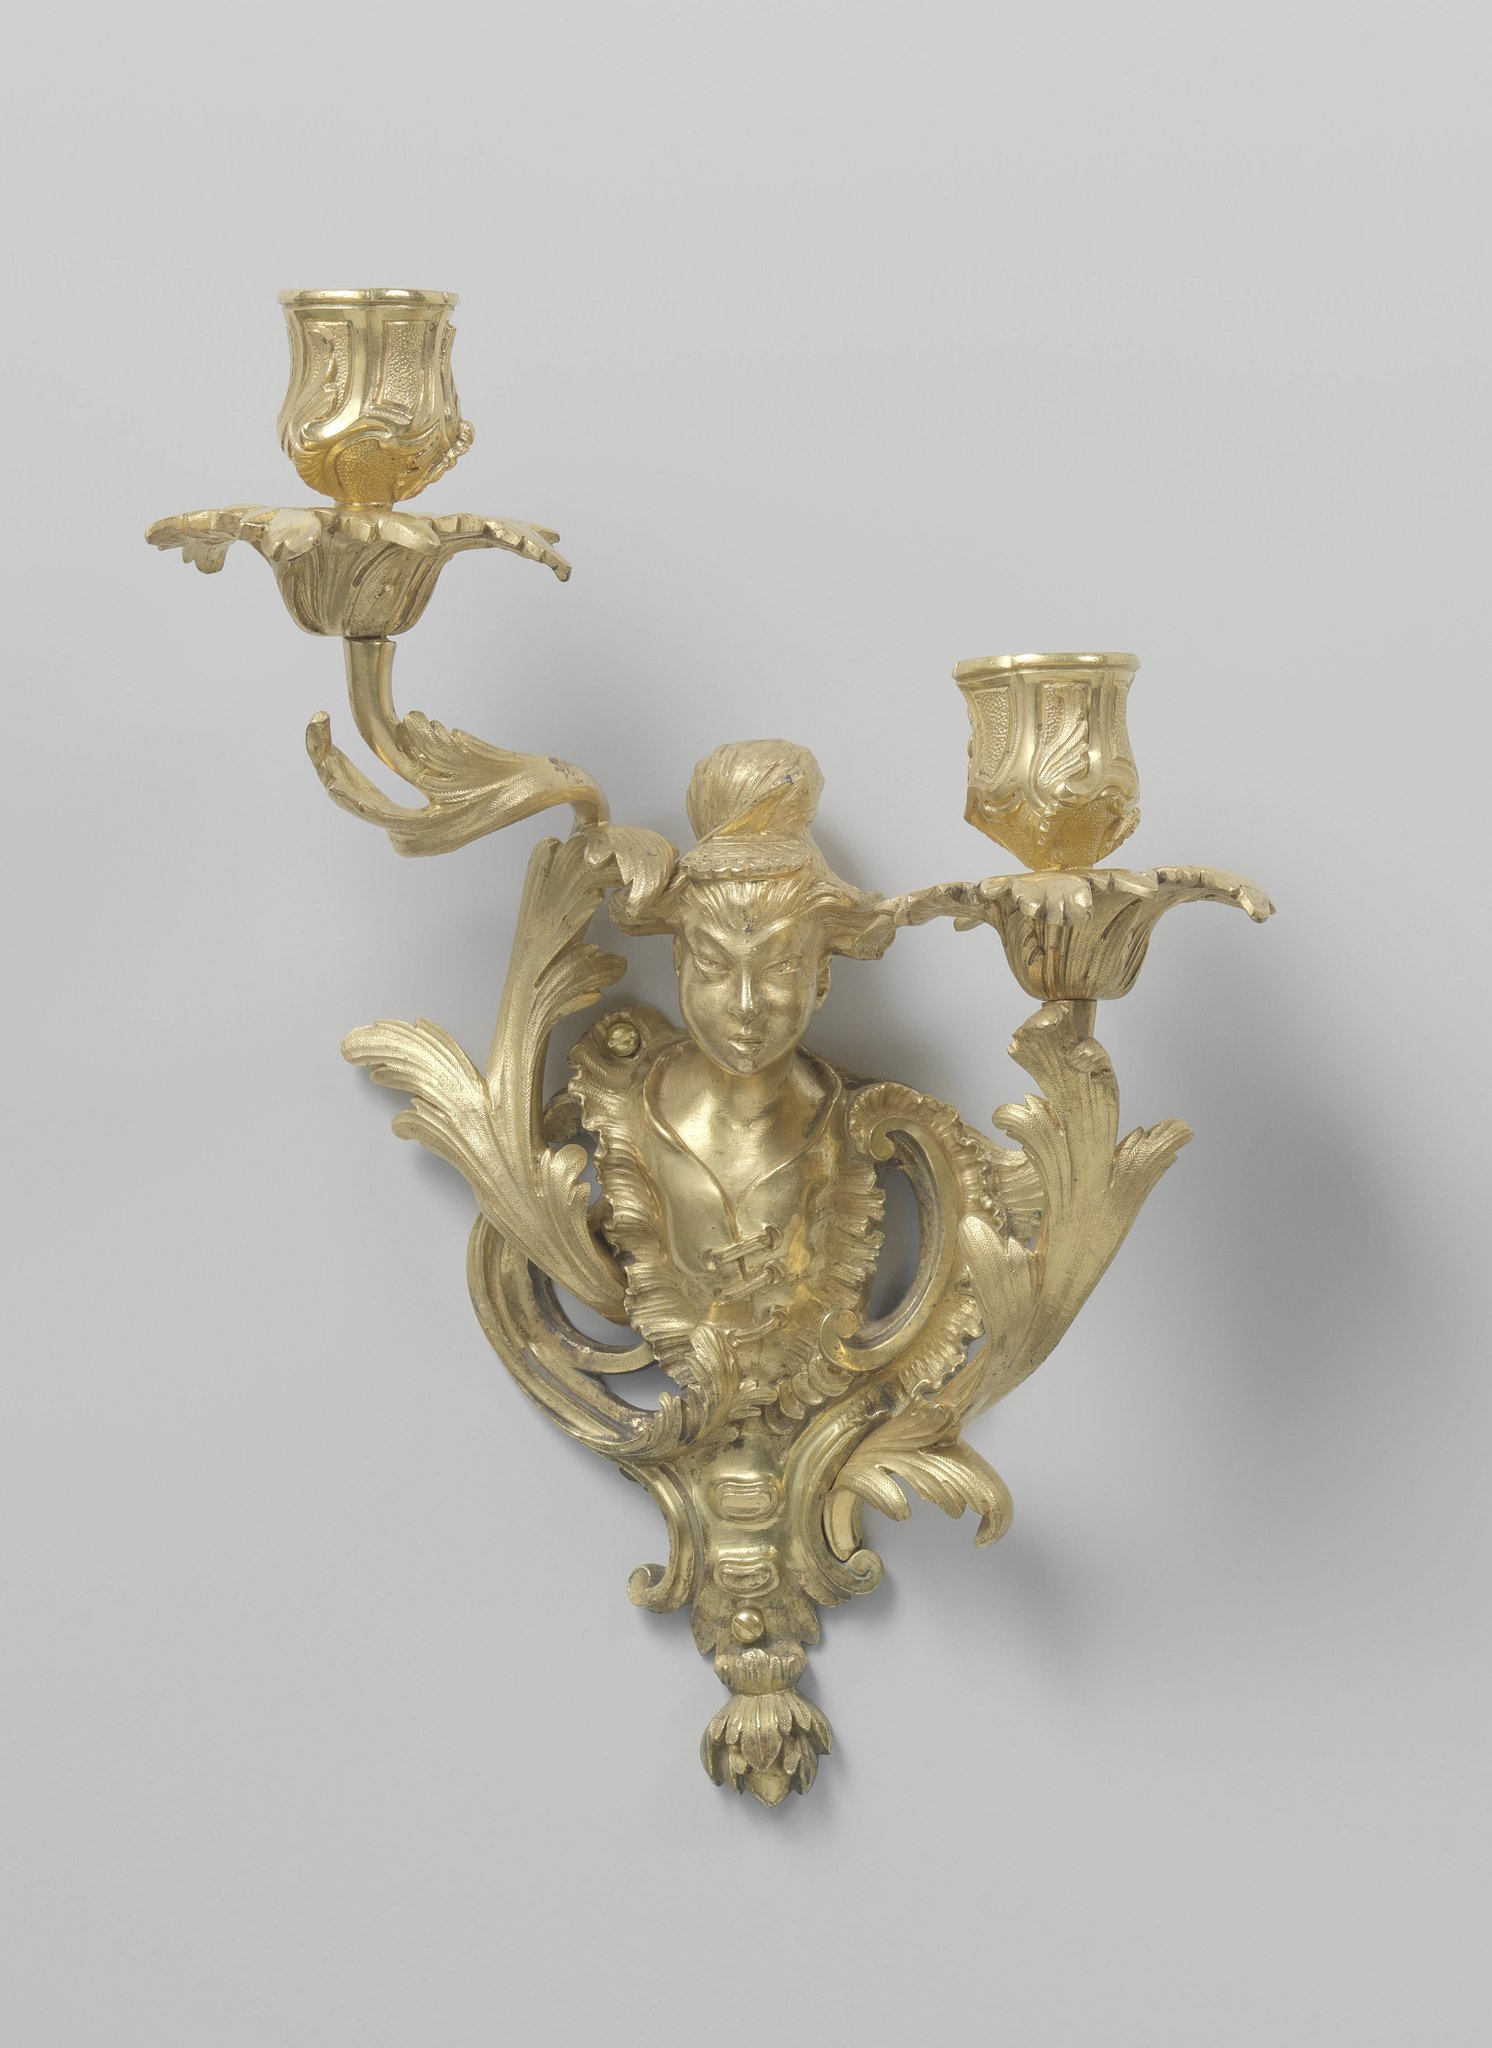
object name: sconce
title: Four wall-lights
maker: Anonymous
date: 1750-1760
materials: bronze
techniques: gilding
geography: paris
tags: ornament derived from plant forms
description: These two pairs of wall-lights feature a man and a woman in a supposedly East-Asian style. They may have been intended for a room decorated with Asian-inspired motifs.